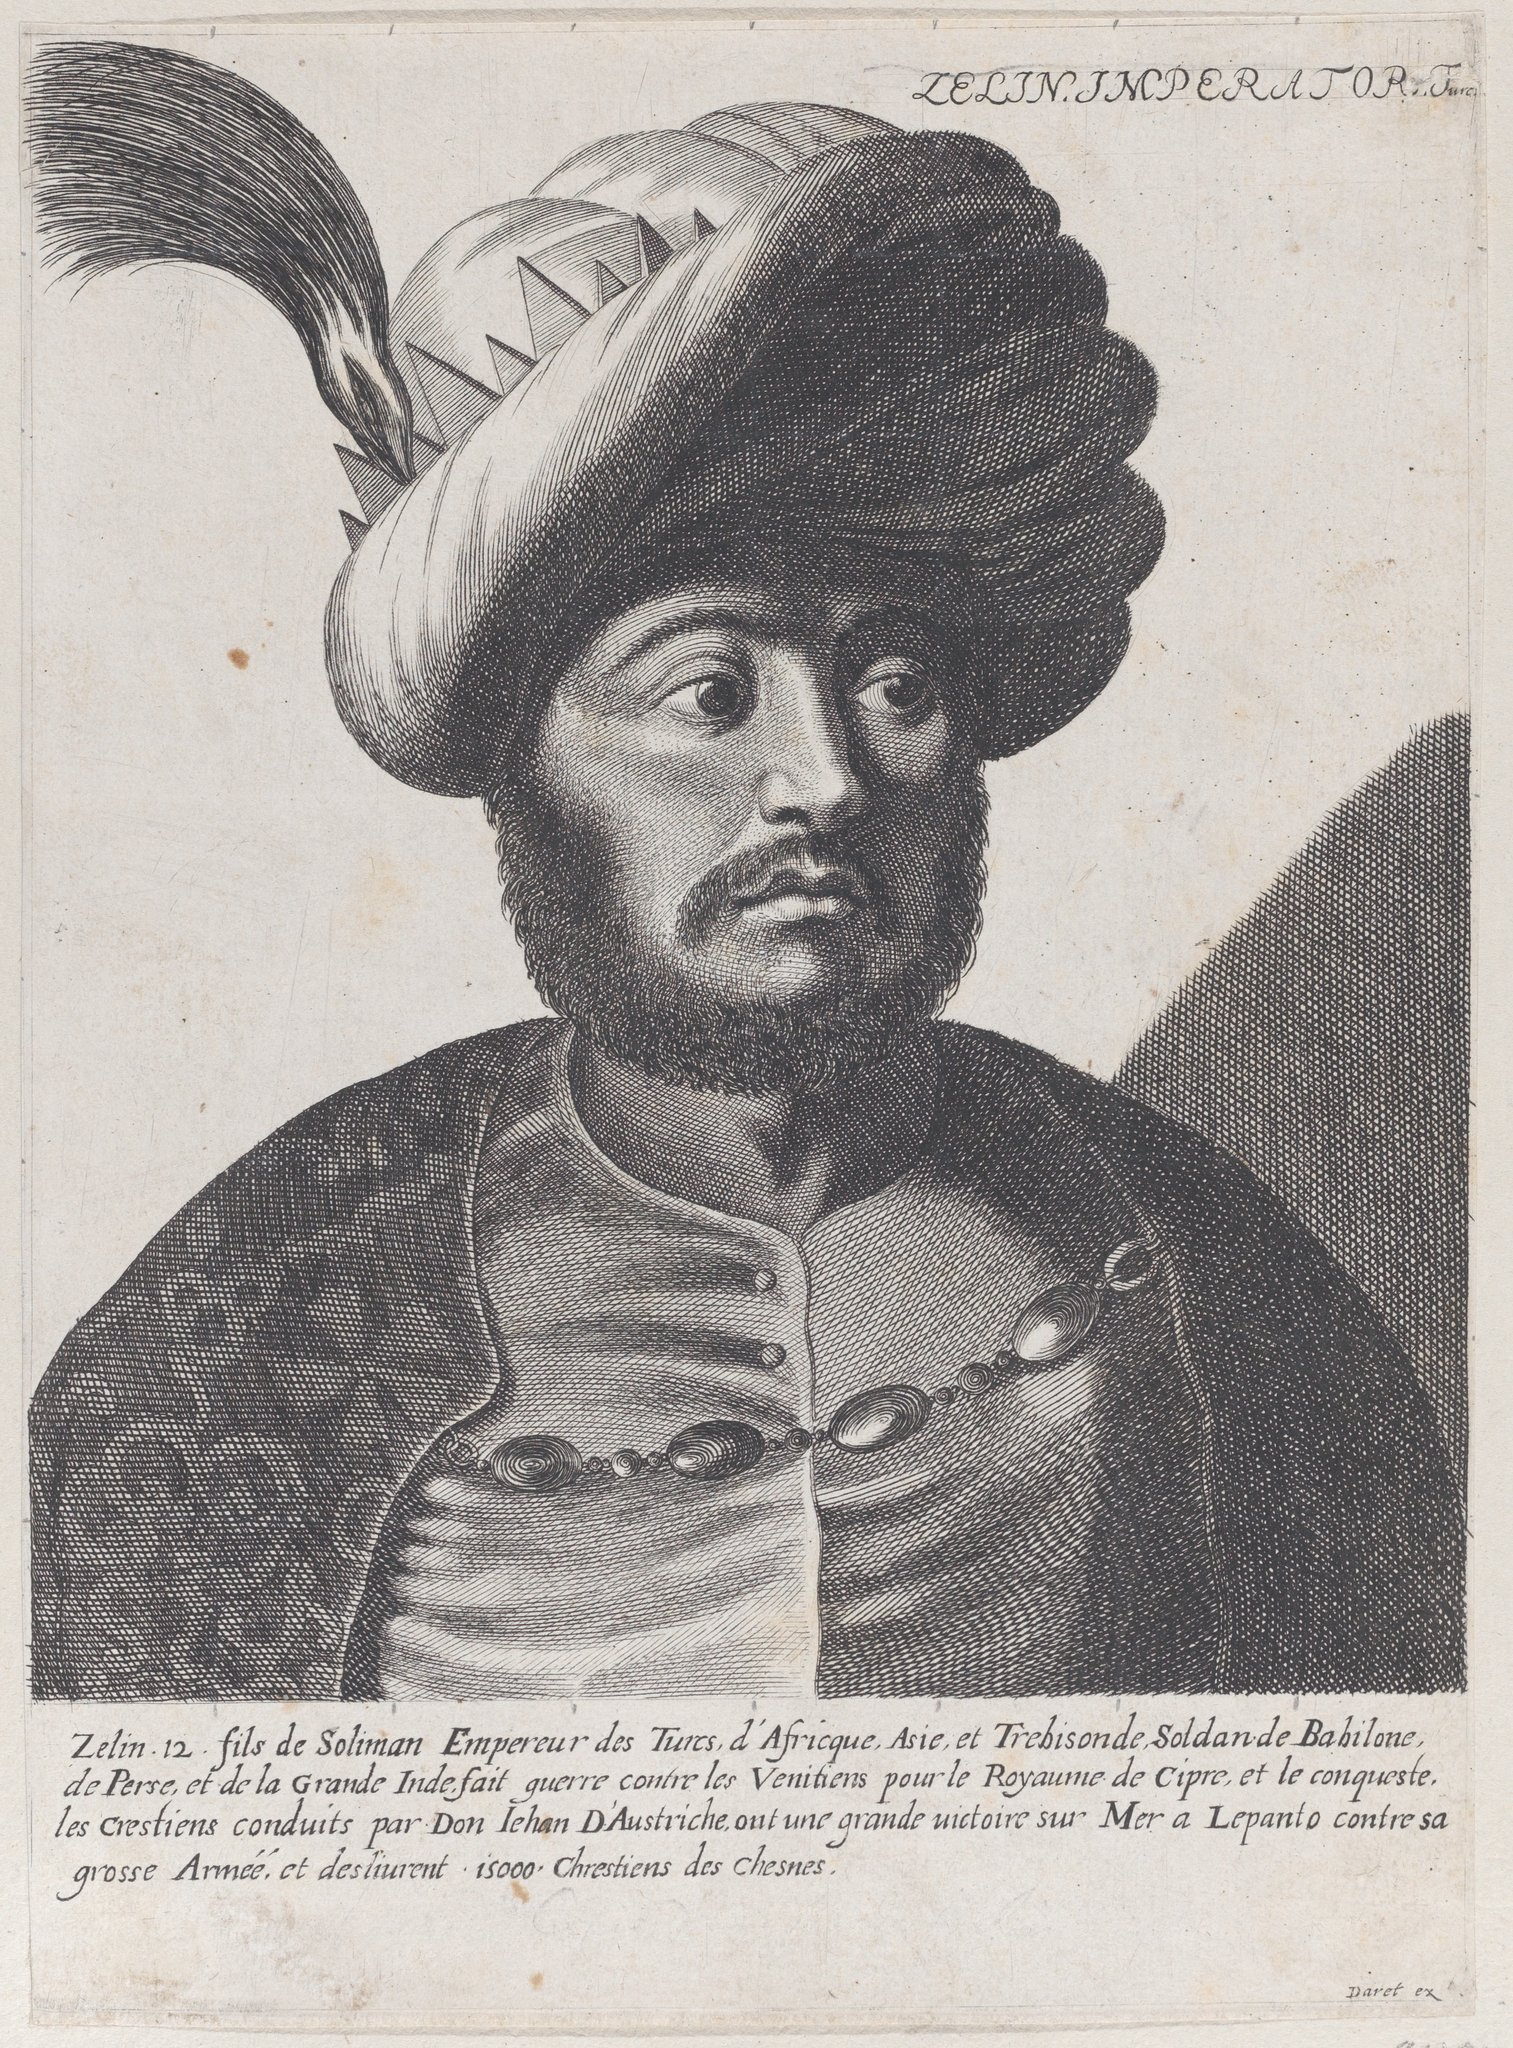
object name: print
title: Turkish Emperor Selim II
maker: Anonymous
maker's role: artist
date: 1624-1675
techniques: engraving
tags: men,portraits